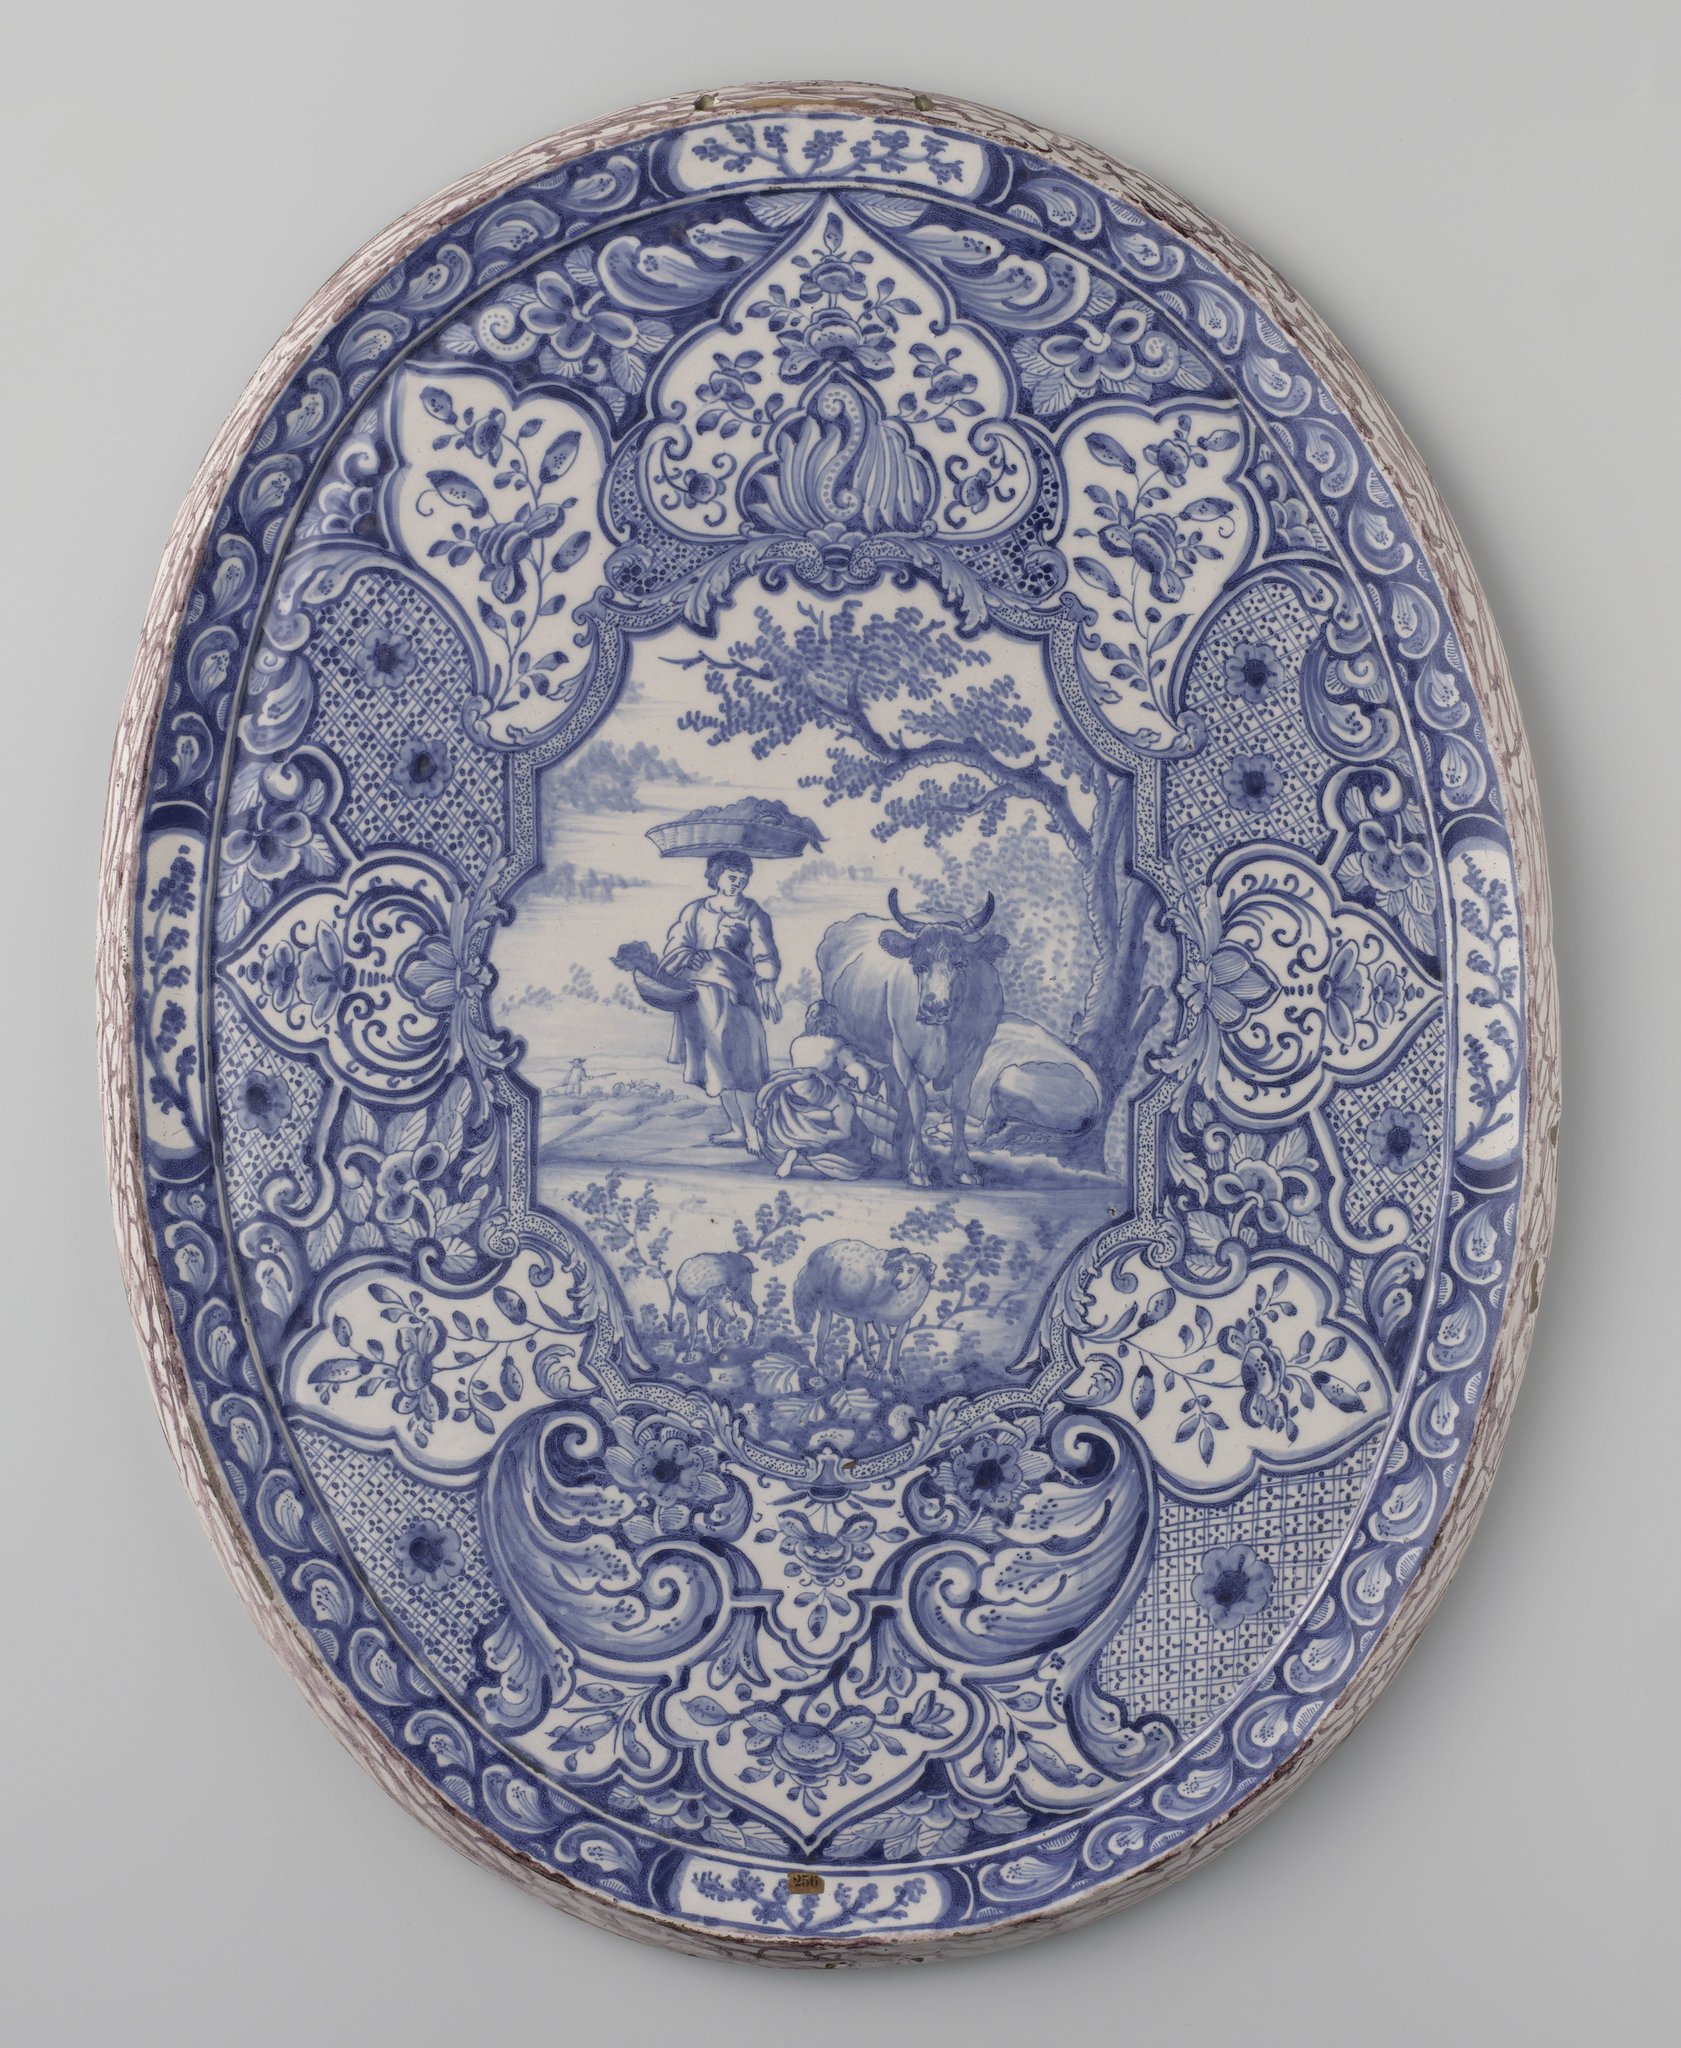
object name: plate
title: Plaat met paars gemarmerde rand en beschilderd in blauw met landelijke scene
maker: Anonymous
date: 1740-1770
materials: faience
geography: amsterdam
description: plaat van faïence. Blauw beschilderd met landelijke scene en versierde rand. De opstaande rand is paars gemarmerd.